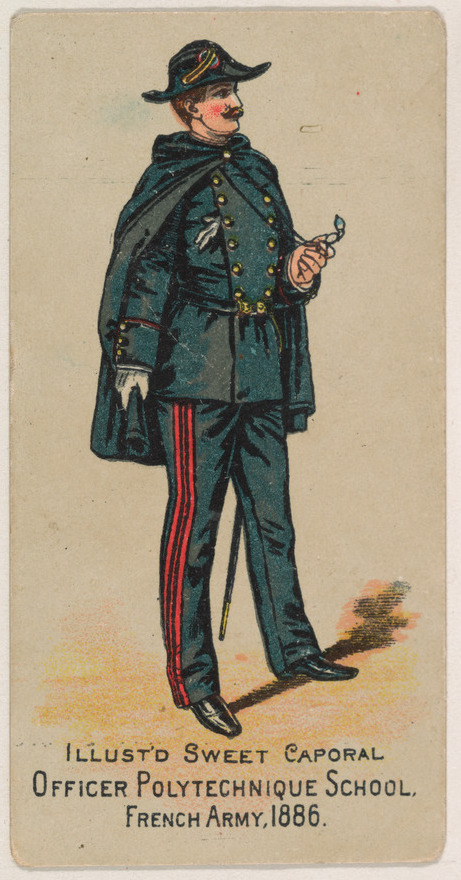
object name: print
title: Officer, Polytechnique School, French Army, 1886, from the Military Series (N224) issued by Kinney Tobacco Company to promote Sweet Caporal Cigarettes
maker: kinney brothers tobacco company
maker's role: publisher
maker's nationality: american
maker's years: 1869-2011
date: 1888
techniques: color lithograph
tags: military,men,profiles